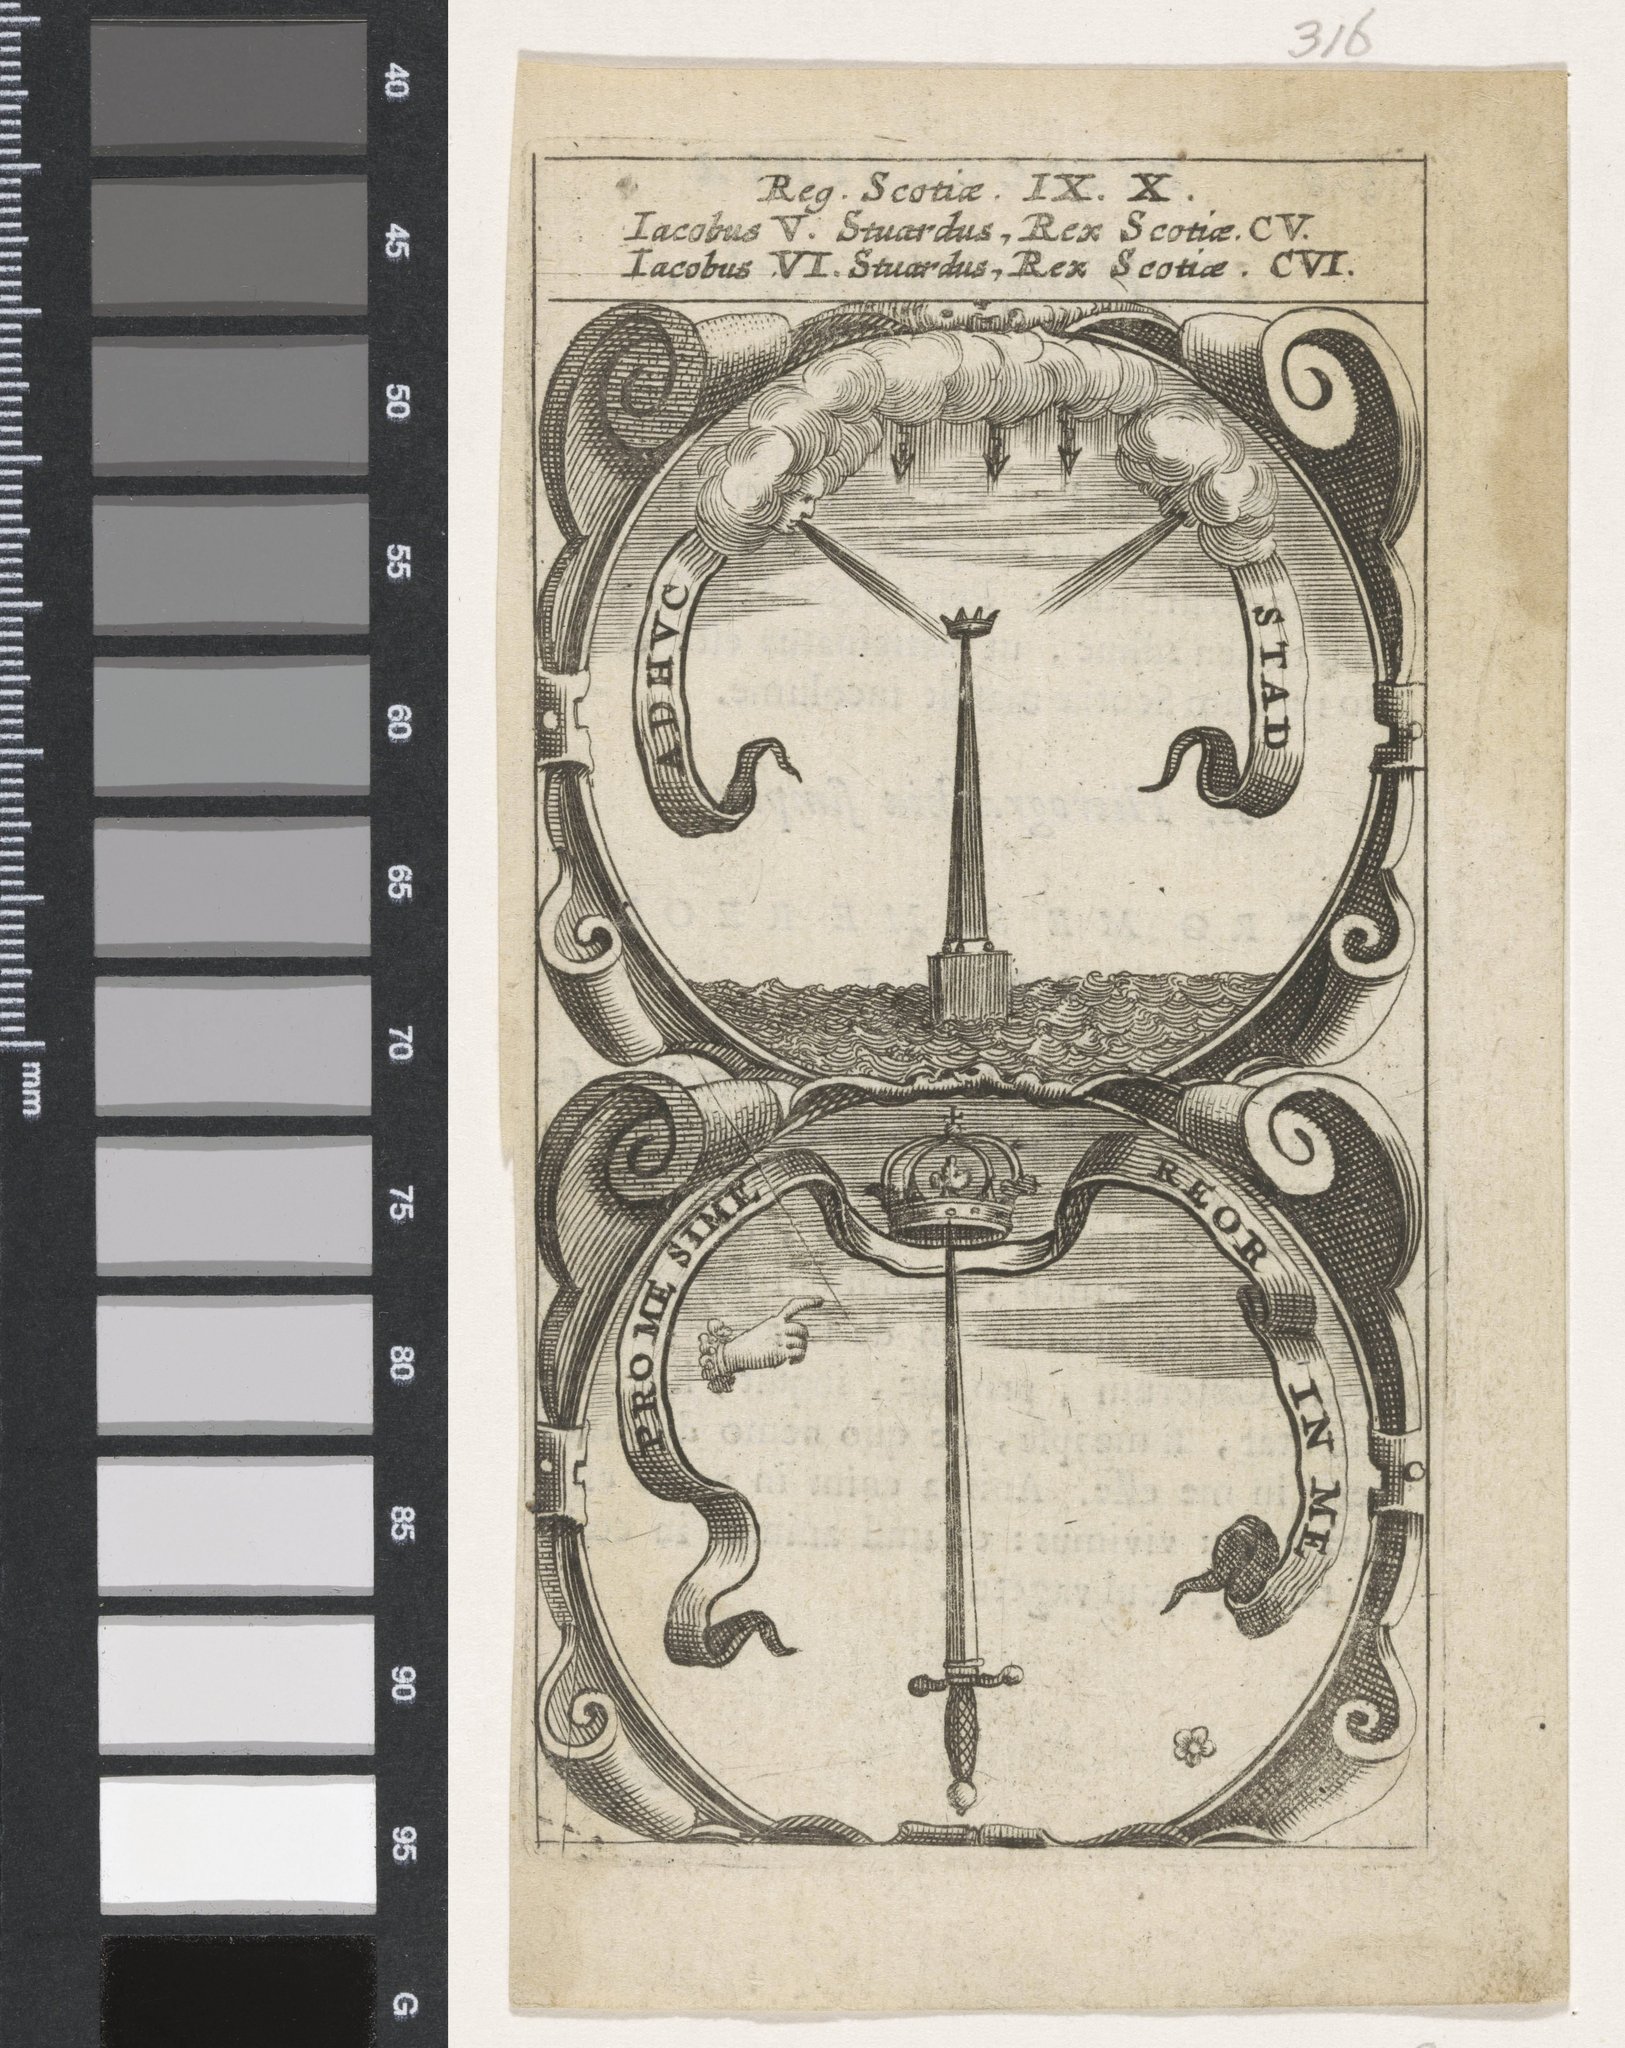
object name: print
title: Kroon boven een obelisk in zee / Kroon op de punt van een zwaard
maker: Anonymous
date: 1666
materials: paper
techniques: engraving, letterpress printing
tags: jacobus i (koning van engeland), crown (symbol of sovereignty), obelisk, needle, hacking and thrusting weapons: sword, winds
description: Een embleem met twee voorstellingen. Boven staat een obelisk in zee. Op de top houden de winden een kroon in evenwicht. Onder een kroon op de punt van een zwaard. De kroon wordt door een hand aangewezen. Het betreffen deviezen van Jacobus V en Jacobus VI van Schotland.